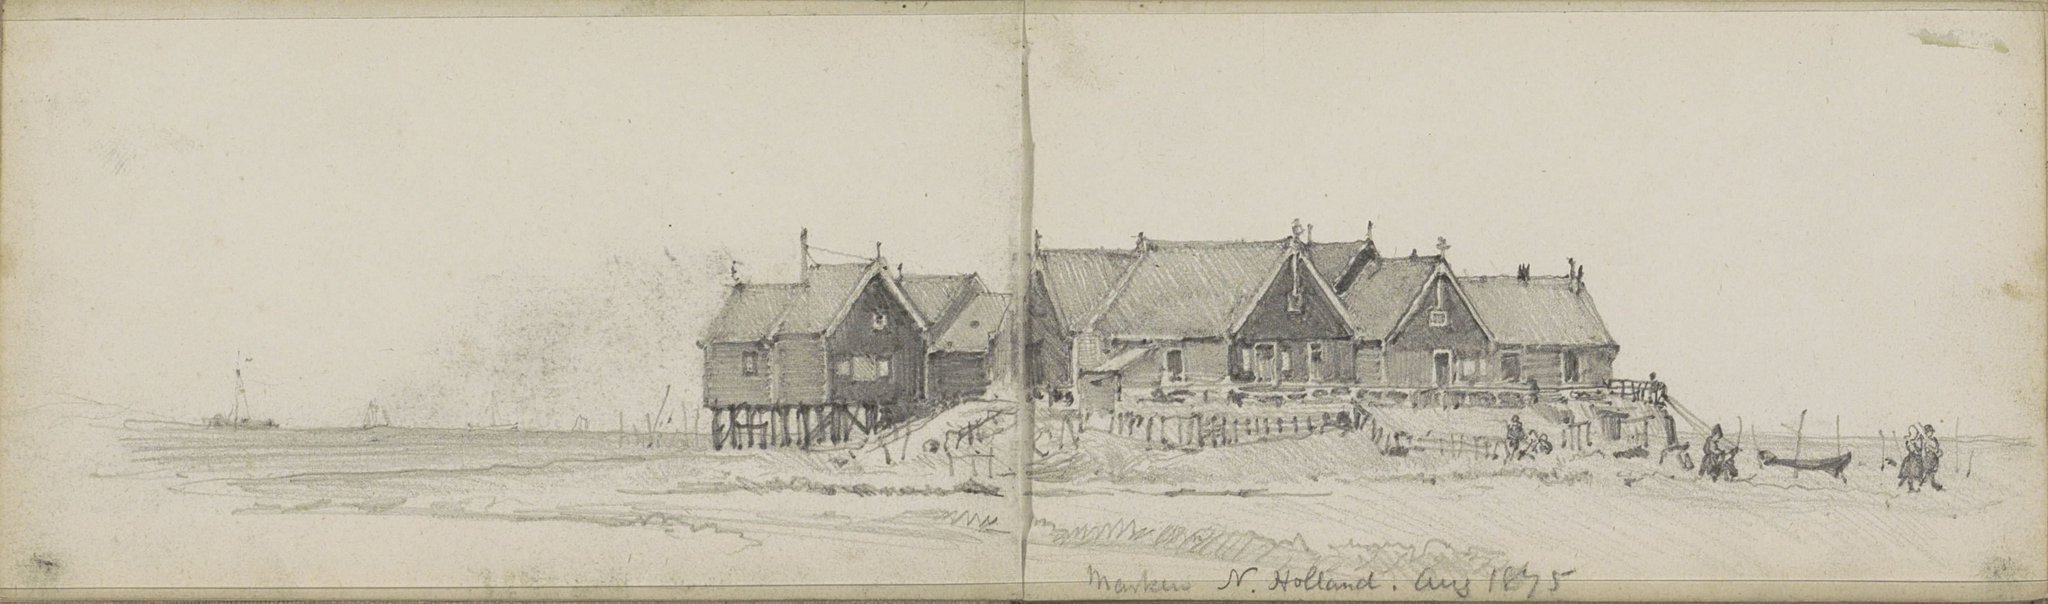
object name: sketchbook leaf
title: Gezicht op Marken met traditionele huizen op palen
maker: george clausen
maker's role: draughtsman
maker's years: 1852-1912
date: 1875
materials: paper, pencil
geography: marken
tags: landscapes with waters, waterscapes, seascapes (in the temperate zone), housing, city-view, and landscape with man-made constructions (+ city(-scape) with figures, staffage)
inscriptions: date and inscription: ‘Marken N. Holland. aug 1875’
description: Op de voorgrond enkele figuren en op de achtergrond een uitzicht over, vermoedelijk, het Markermeer. Blad 6 verso en 7 recto uit een schetsboek met 46 bladen.